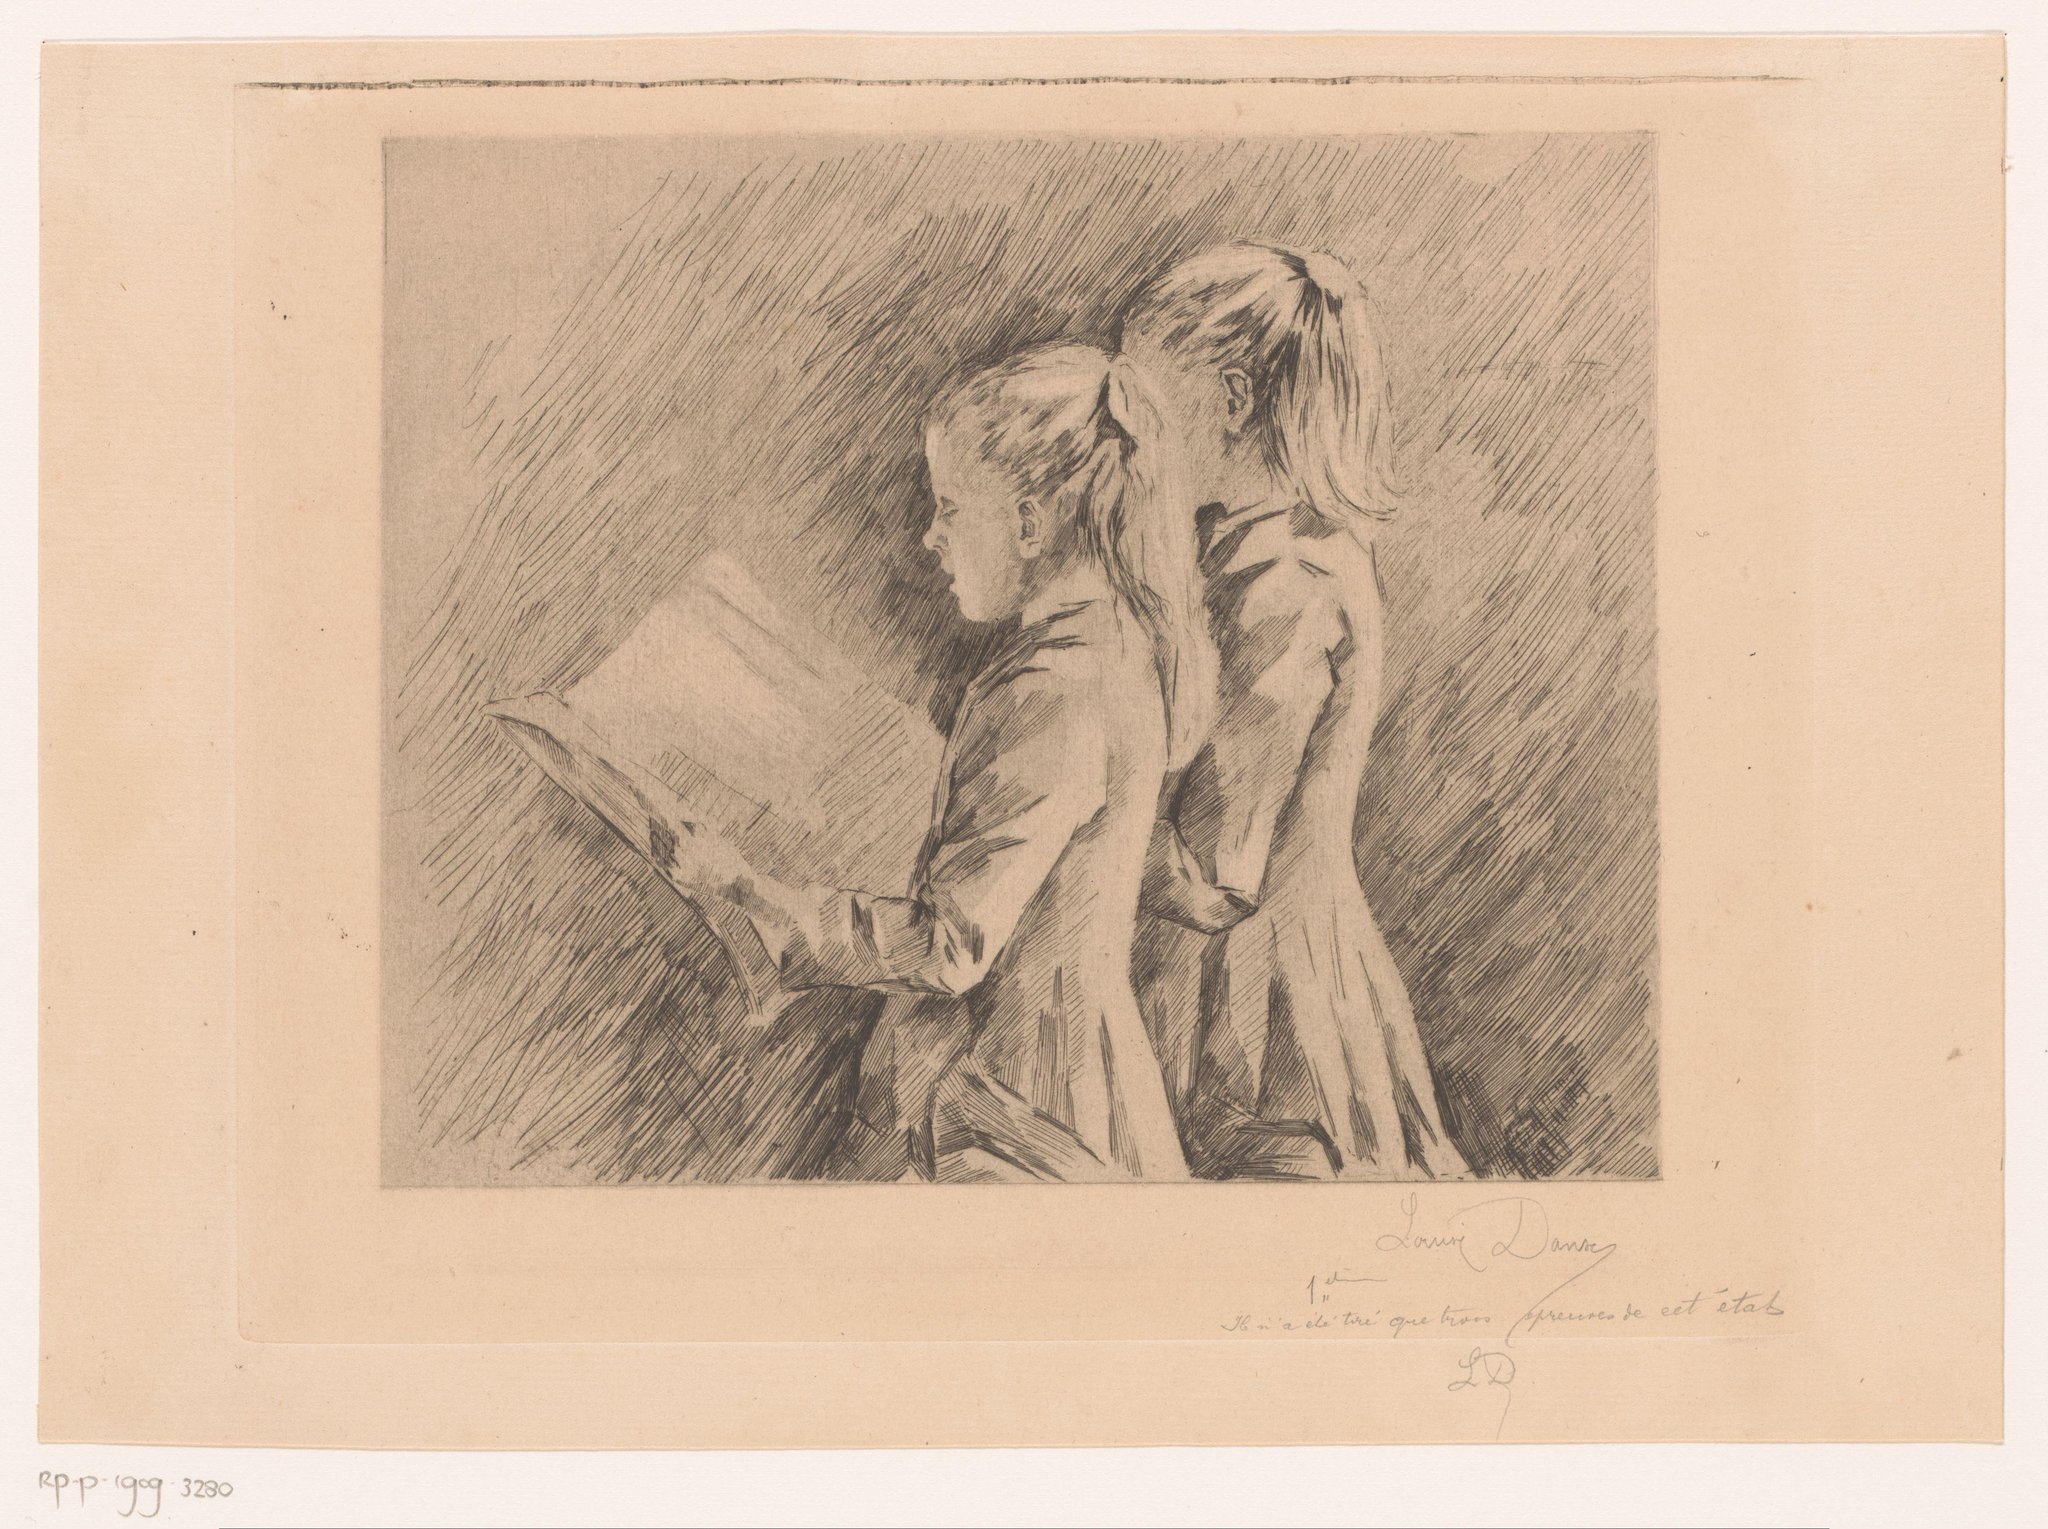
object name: print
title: Twee meisjes zingen van bladmuziek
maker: louise danse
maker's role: painter, print maker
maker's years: 1867-1948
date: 1877-1909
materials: paper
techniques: etching, intaglio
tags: children singing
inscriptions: annotation: ‘1 etat; Il n'a été tiré que trois epreuves de cet état’, collector's mark: Lugt 2228